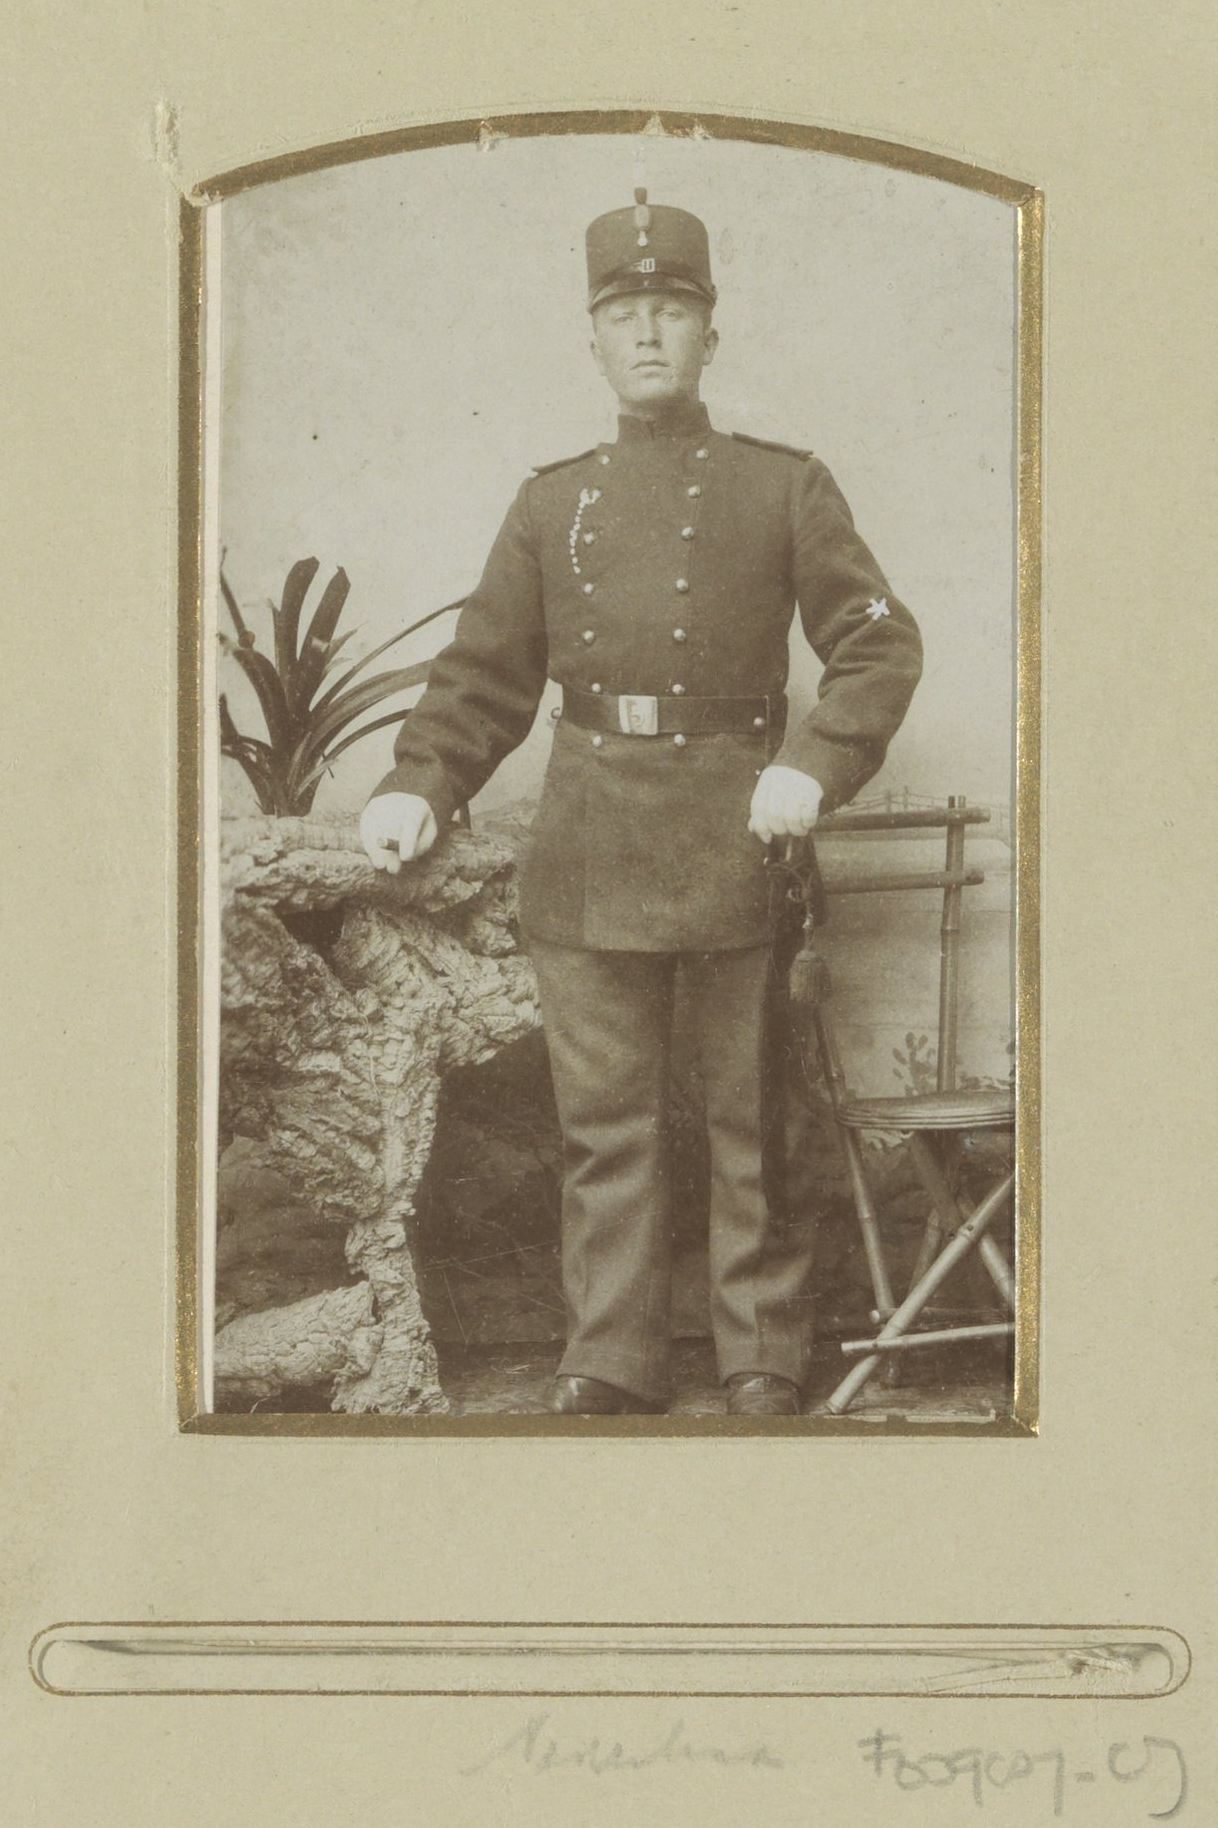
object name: album leaf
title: Portret van een (vermoedelijk) Nederlandse militair, staand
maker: theodorus ferdinant van de pol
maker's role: fotograaf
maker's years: 1861-1953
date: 1890-1920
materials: cardboard, paper, photographic support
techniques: daylight paper print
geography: amersfoort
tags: studio requisites ~ photographer, warfare; military affairs, (military) uniforms, division of armed forces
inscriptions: address: ‘Amersfoort Korte Beekstraat aan het Plantsoen / Barneveld Langstraat.’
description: Onderdeel van Album met cartes-de-visite en kabinetfoto's van militairen in uniform.